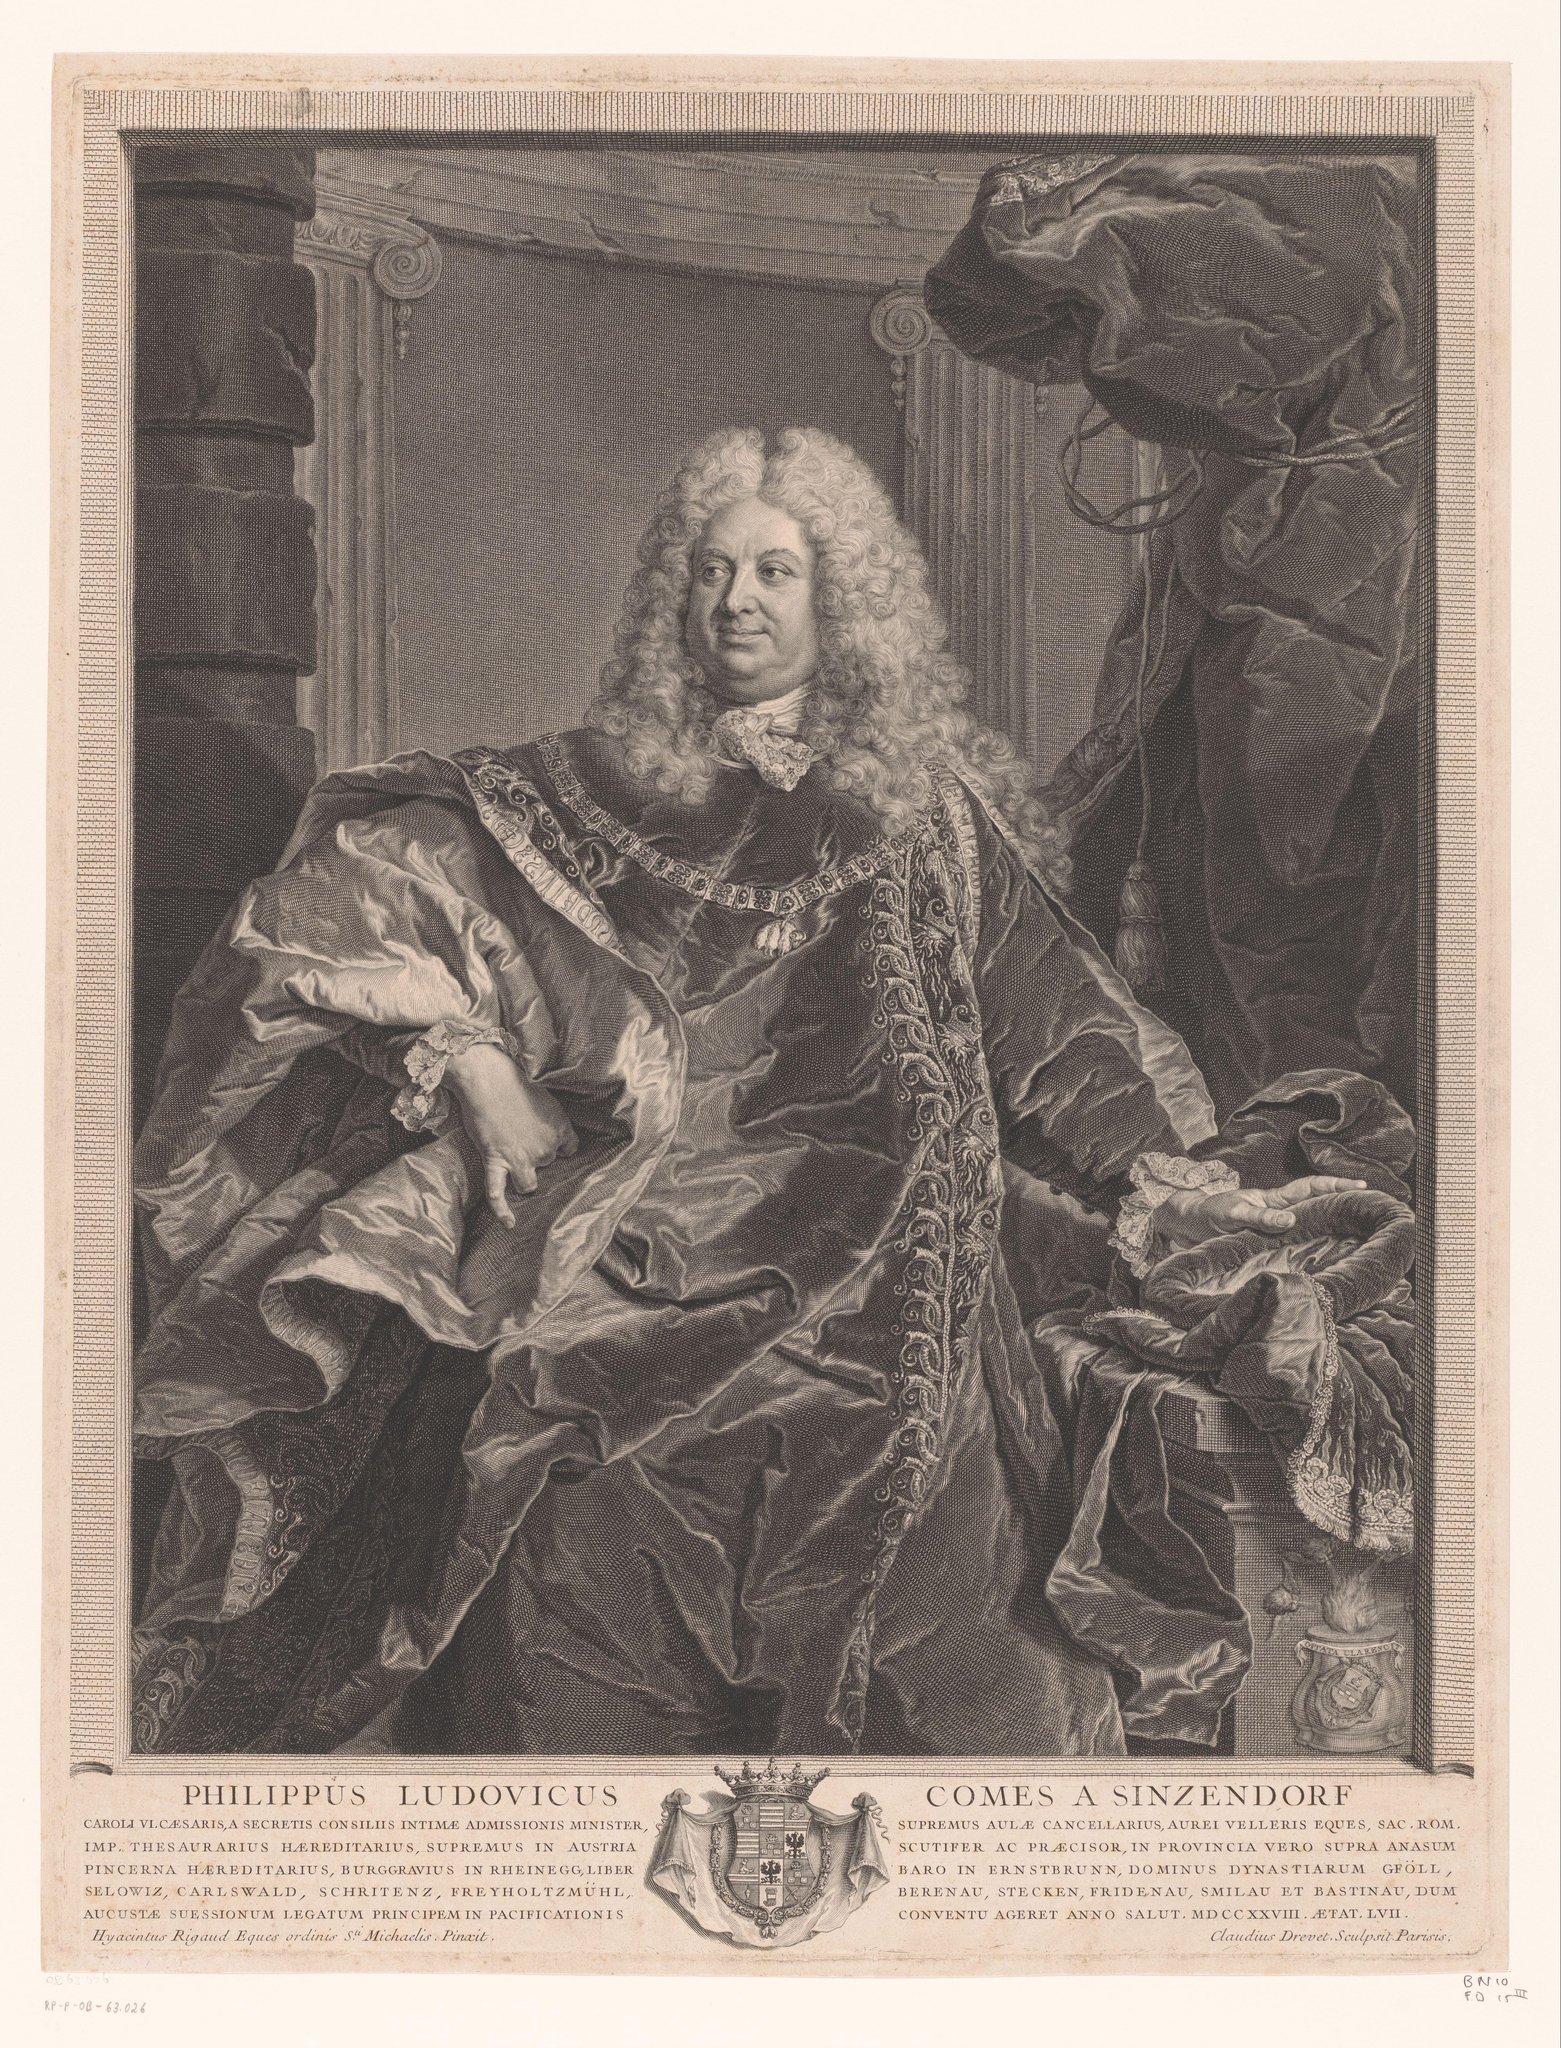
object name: print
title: Portret van Philipp Ludwig Wenzel von Sinzendorf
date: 1728-1781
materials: paper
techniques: engraving, etching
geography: paris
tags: historical persons, diplomacy, diplomat, armorial bearing, heraldry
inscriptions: collector's mark: Lugt 240